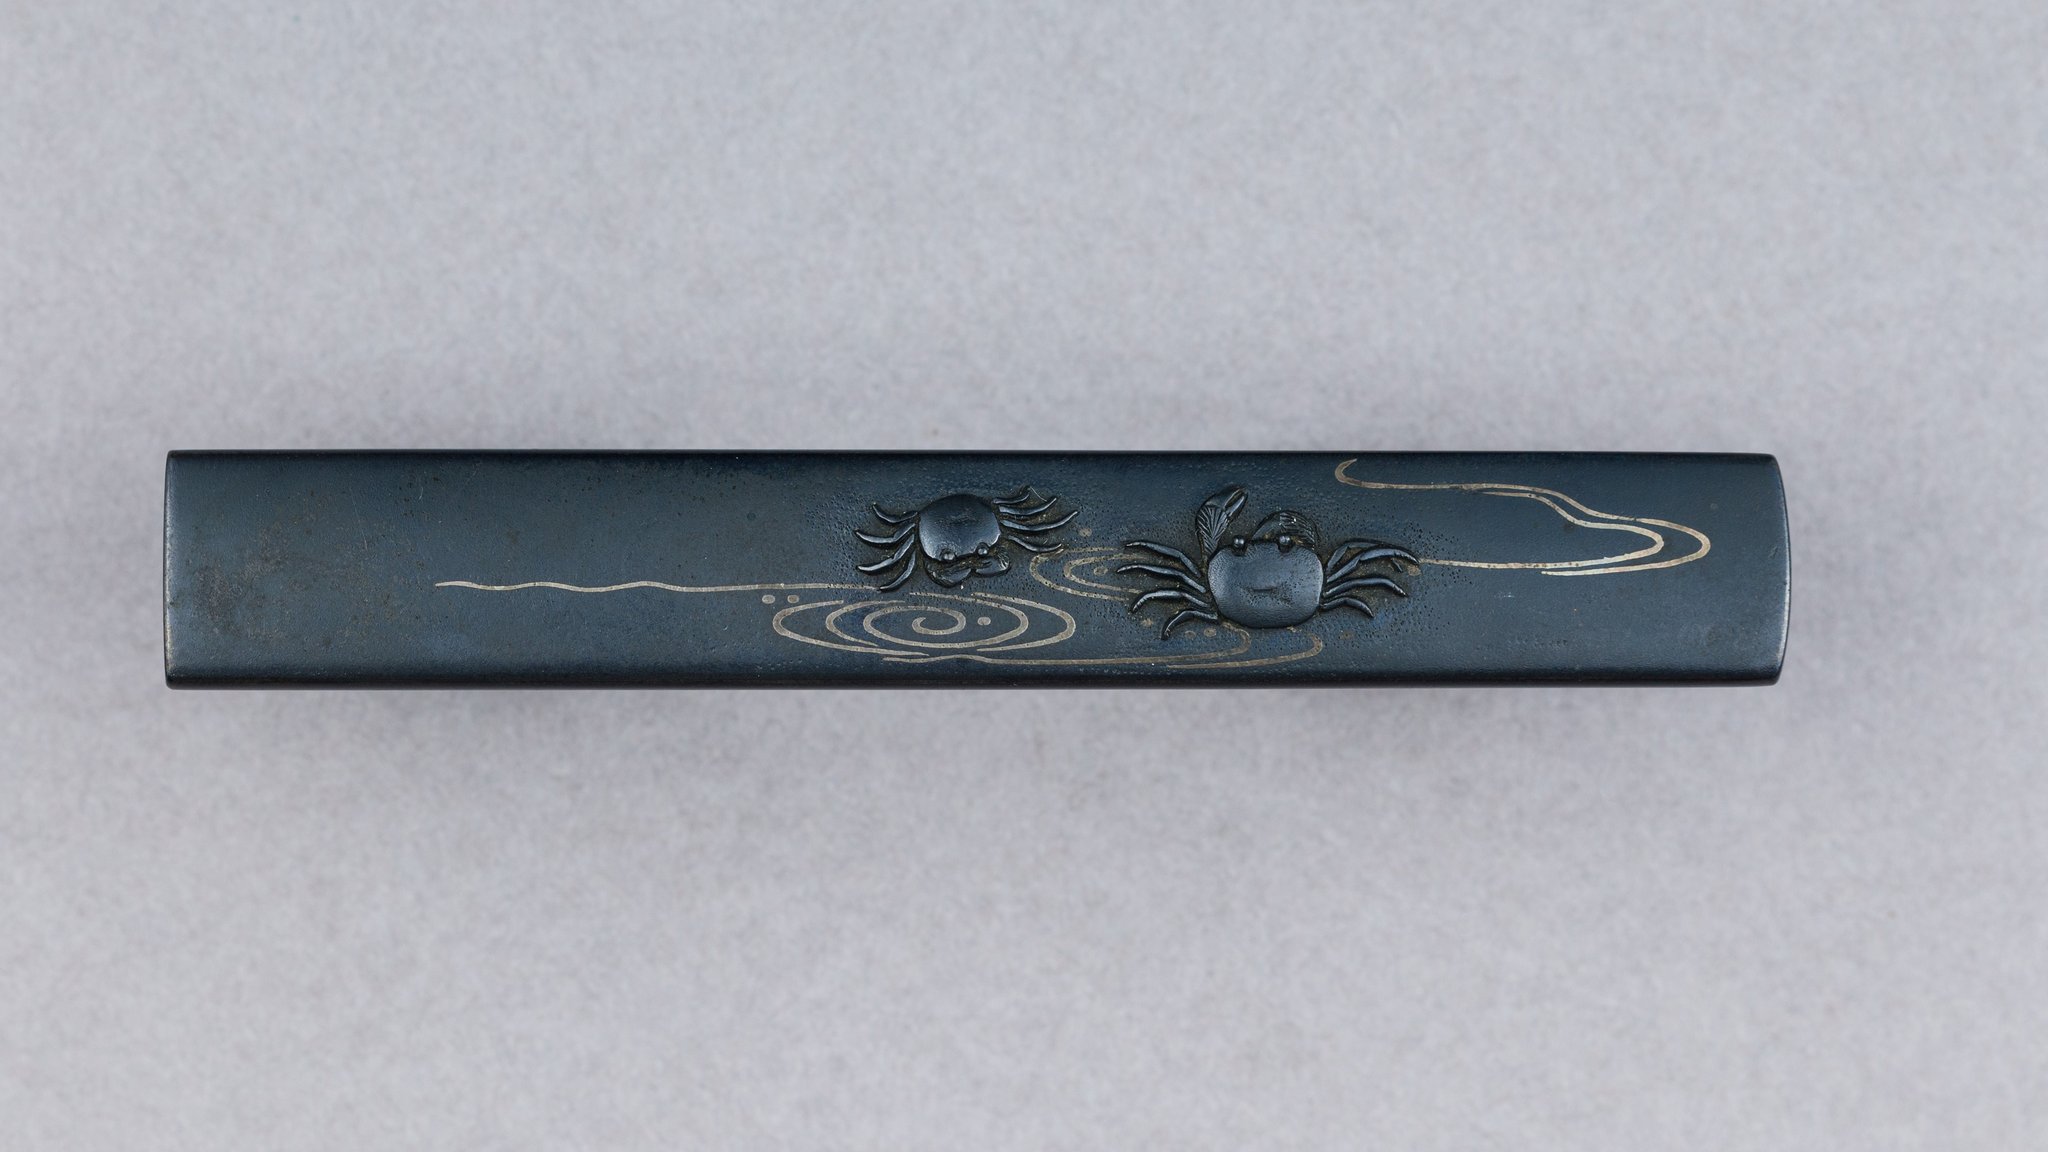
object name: knife handle kozuka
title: Knife Handle (Kozuka)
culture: japanese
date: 1801-1900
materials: gold alloy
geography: japan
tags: crabs